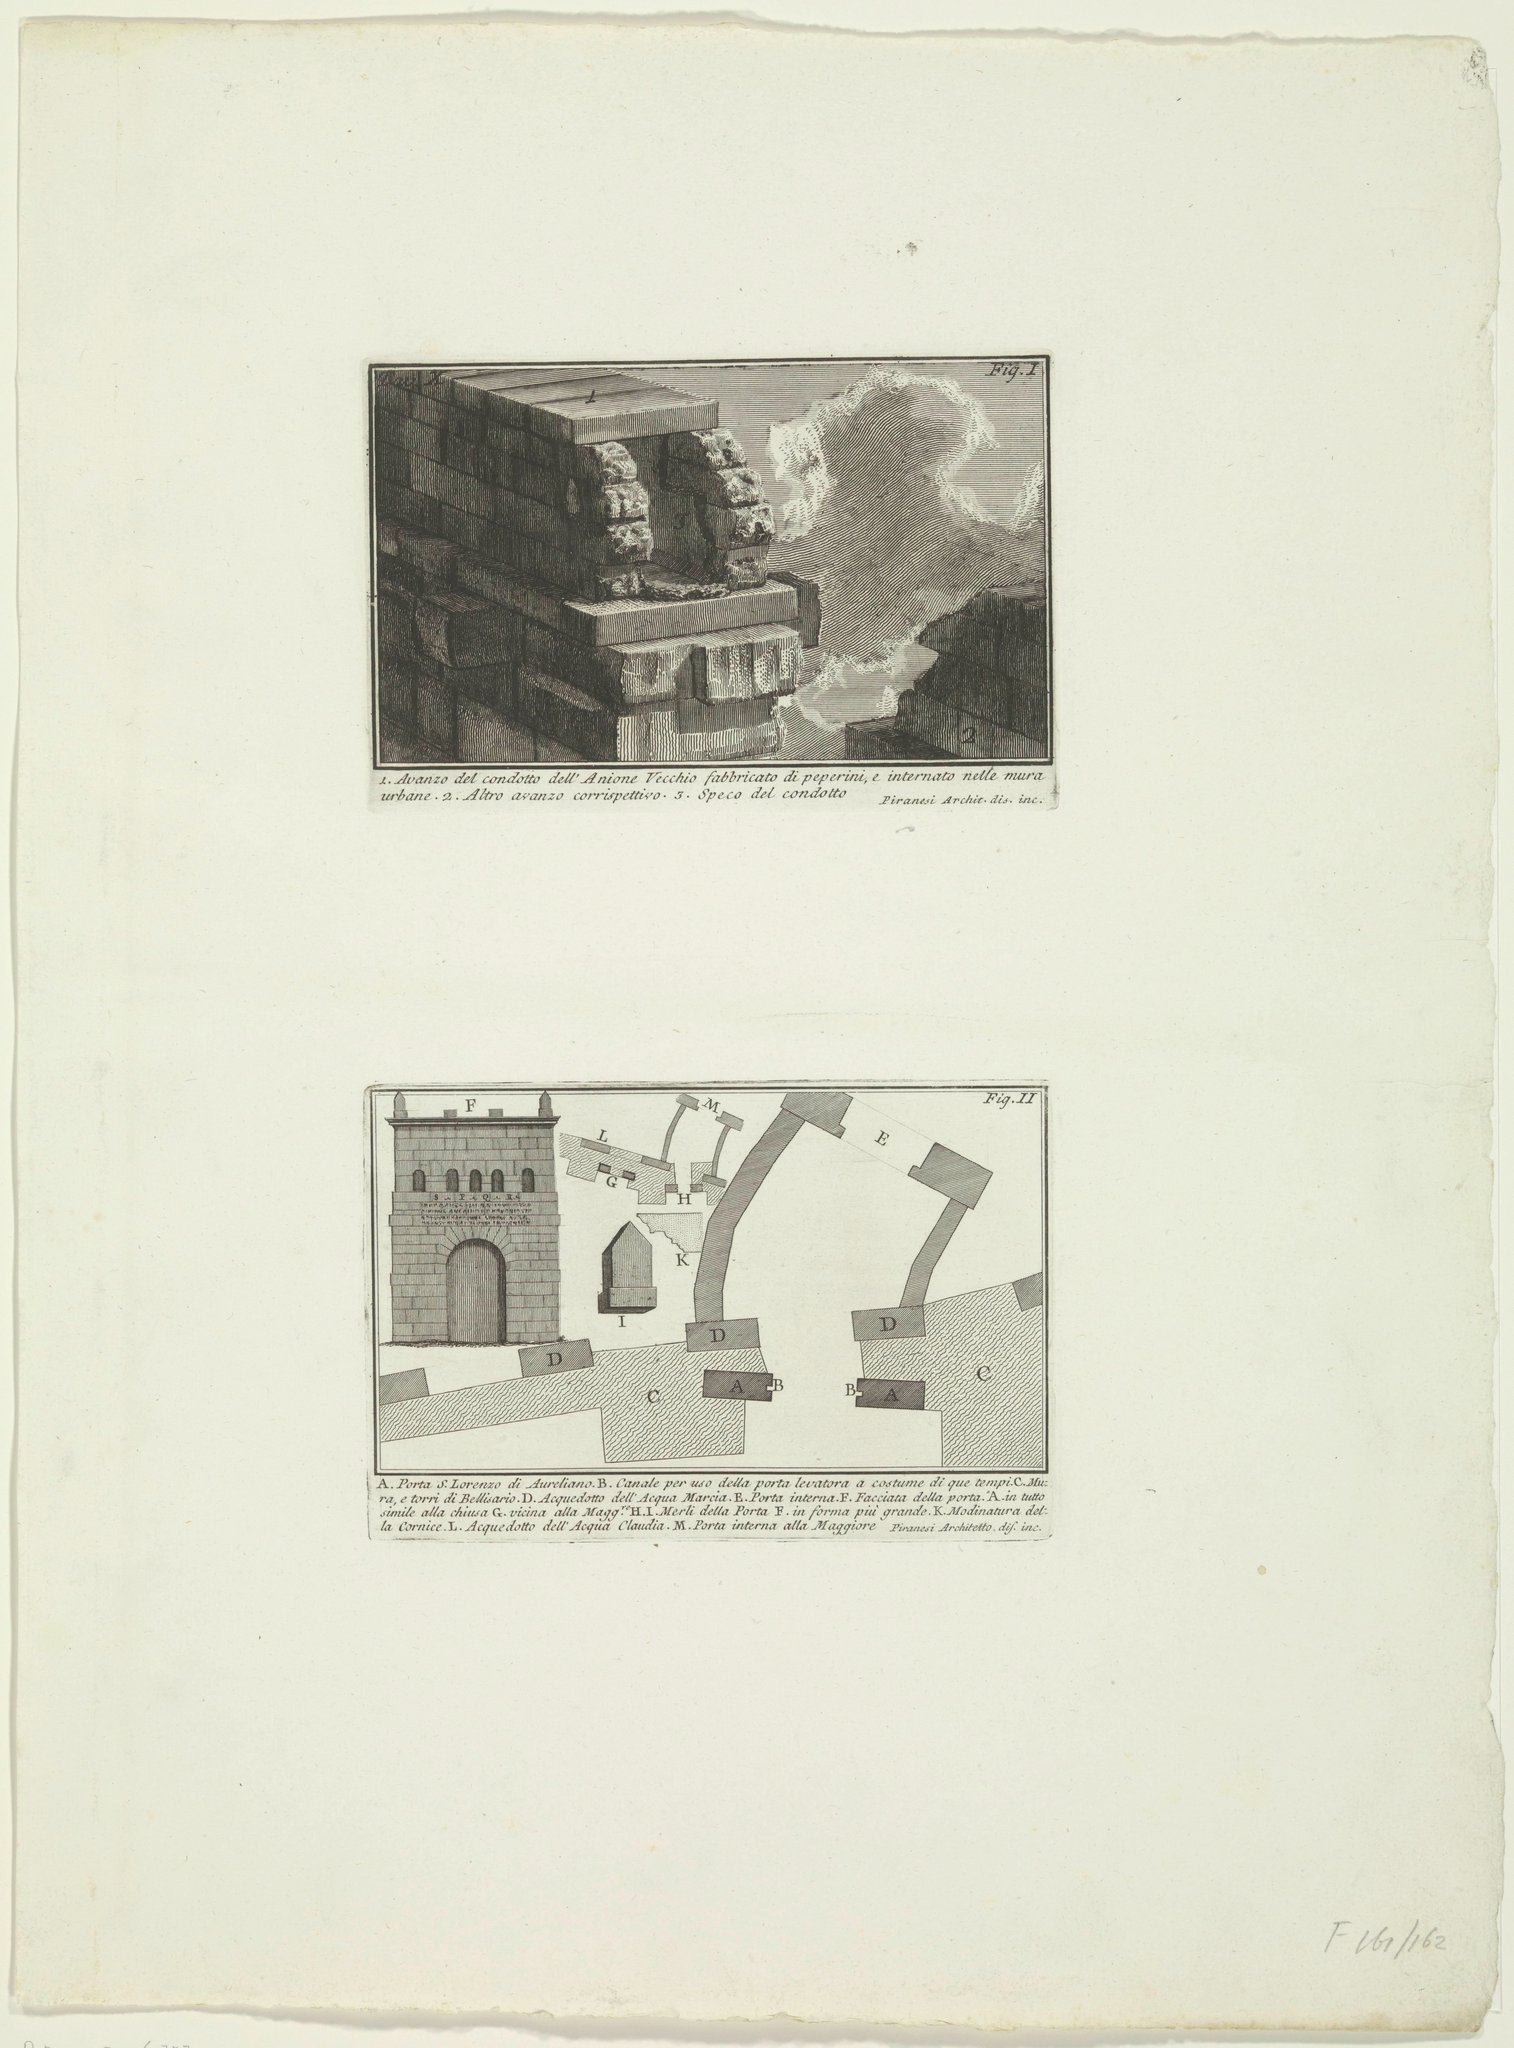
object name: print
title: Aquaduct Aqua Anio Vetus en stadspoort Porta Tiburtina te Rome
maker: giovanni battista piranesi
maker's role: designer, draughtsman, print maker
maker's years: 1720-1778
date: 1756-1757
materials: paper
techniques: etching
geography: rome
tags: ruin of a building ~ architecture, aqueduct (~ water supply), city-gate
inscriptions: collector's mark: Lugt 2228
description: Blad met twee voorstellingen van Romeinse bouwwerken. Boven: restanten van het aquaduct Aqua Anio Vetus. Genummerd linksboven: Tav. X. Genummerd rechtsboven: Fig. I. Verklarende lijst met letters in ondermarge. Onder: schematische weergave van de stadspoort Porta Tiburtina in de Aureliaanse Muur en een plattegrond van de omgeving. Genummerd rechtsboven: Fig. II. Verklarende lijst met letters in ondermarge.